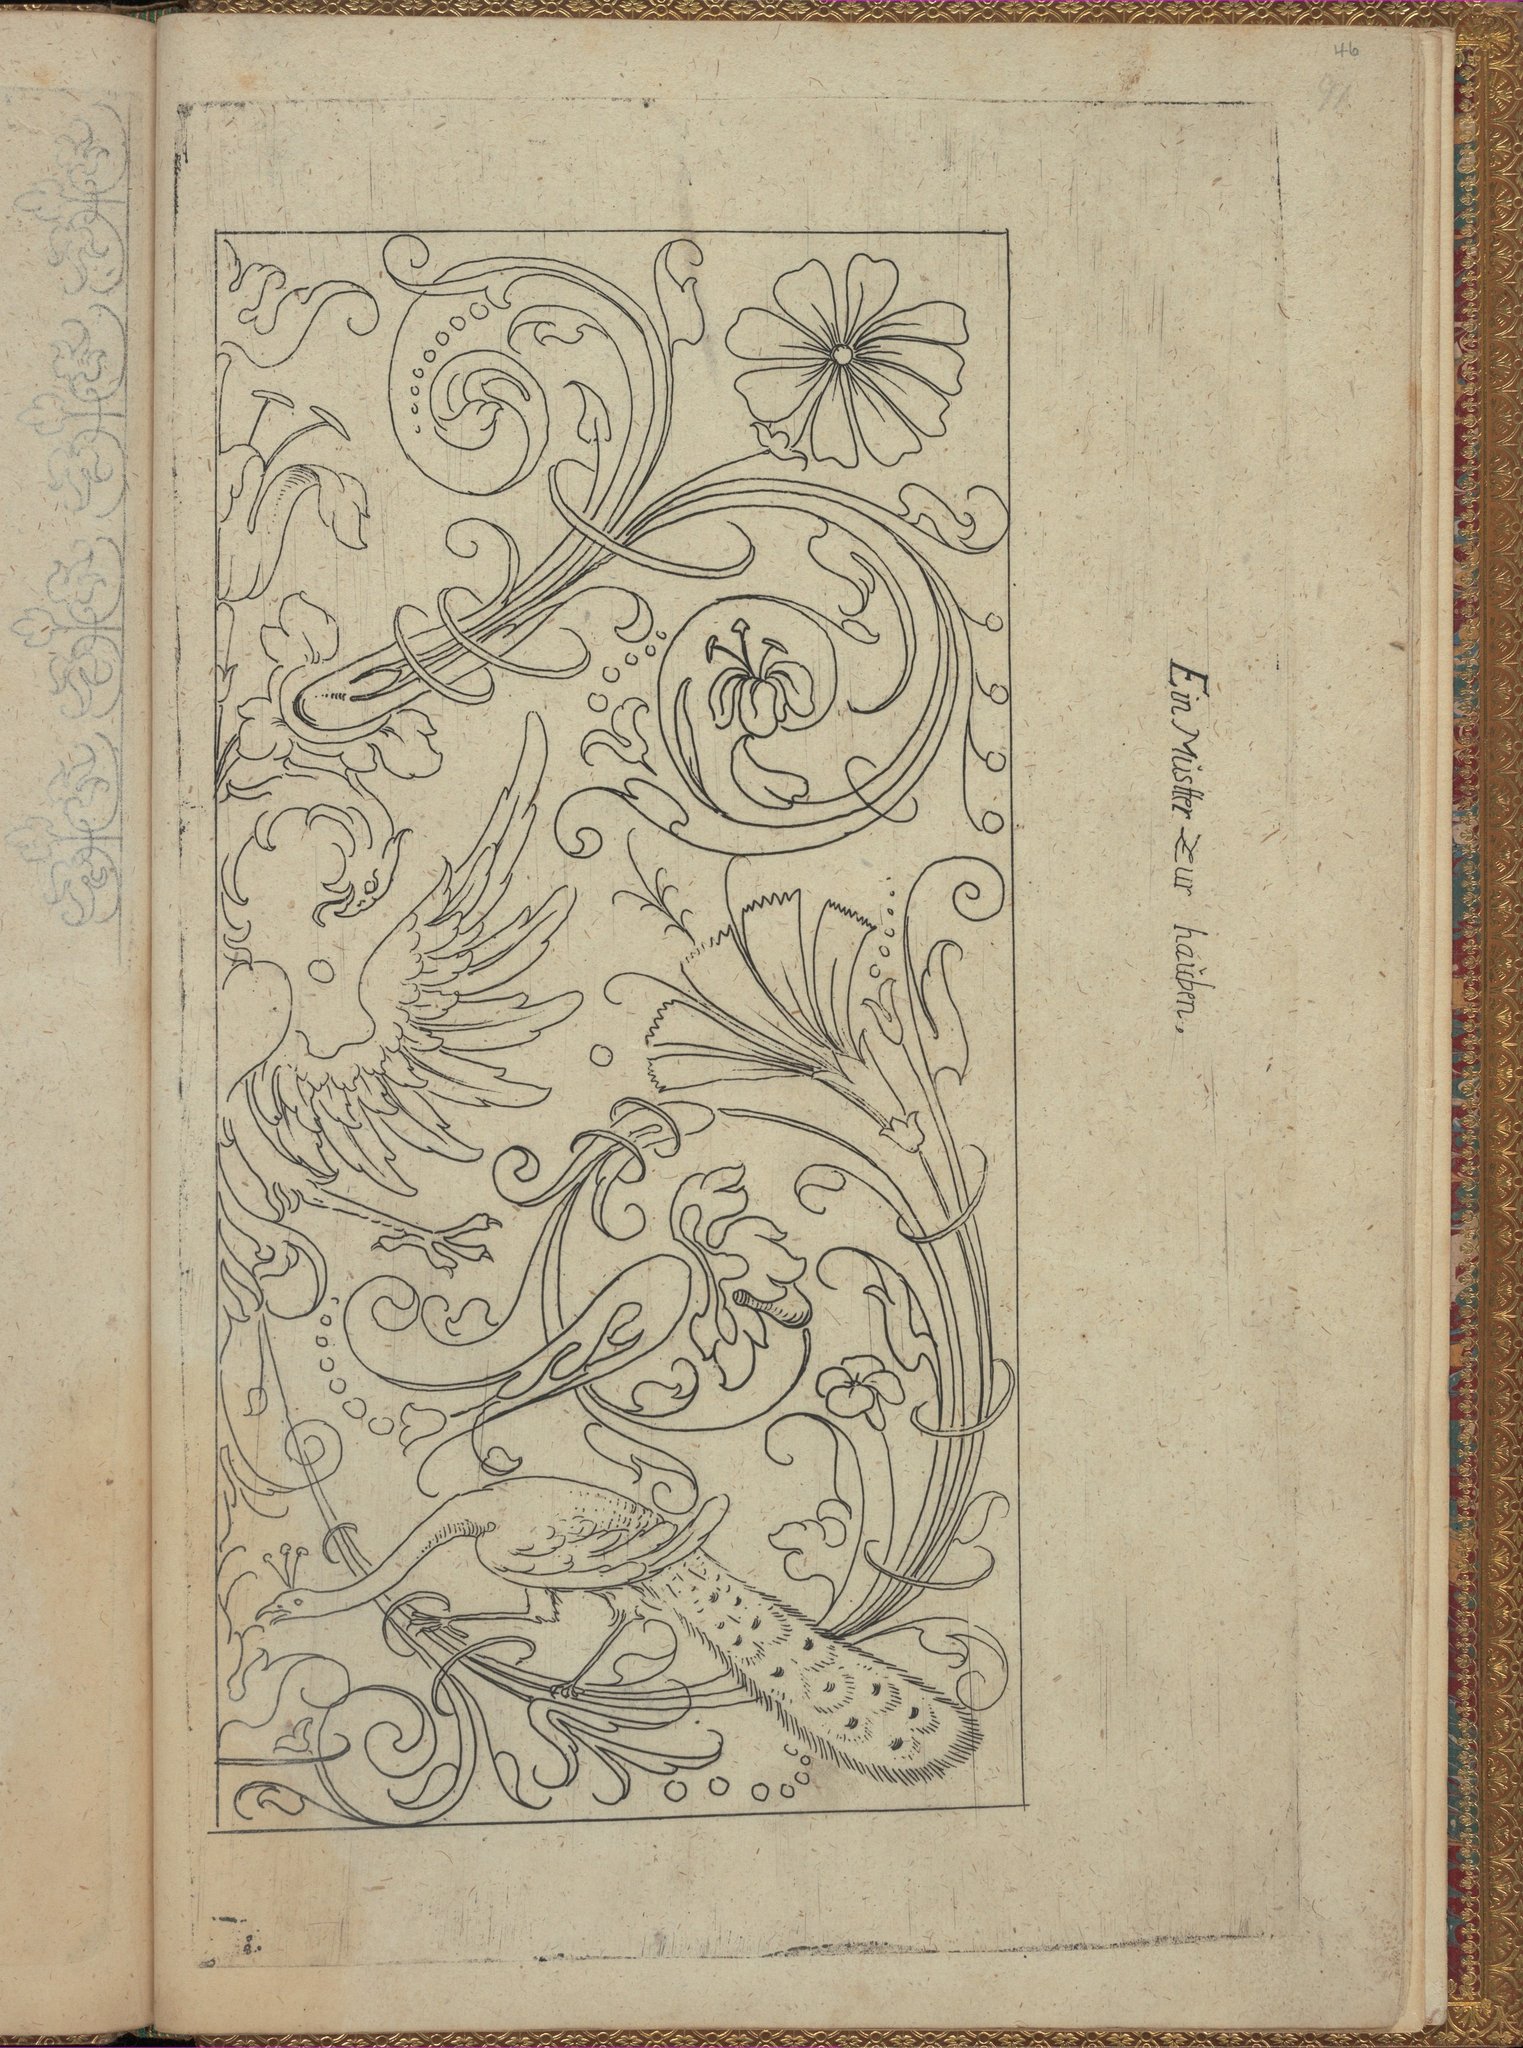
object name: book print ornament architecture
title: New Modelbüch (Page 46v)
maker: andreas bretschneider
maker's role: designer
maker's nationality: german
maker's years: 1573-1645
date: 1615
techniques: etching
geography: germany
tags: peacocks,flowers